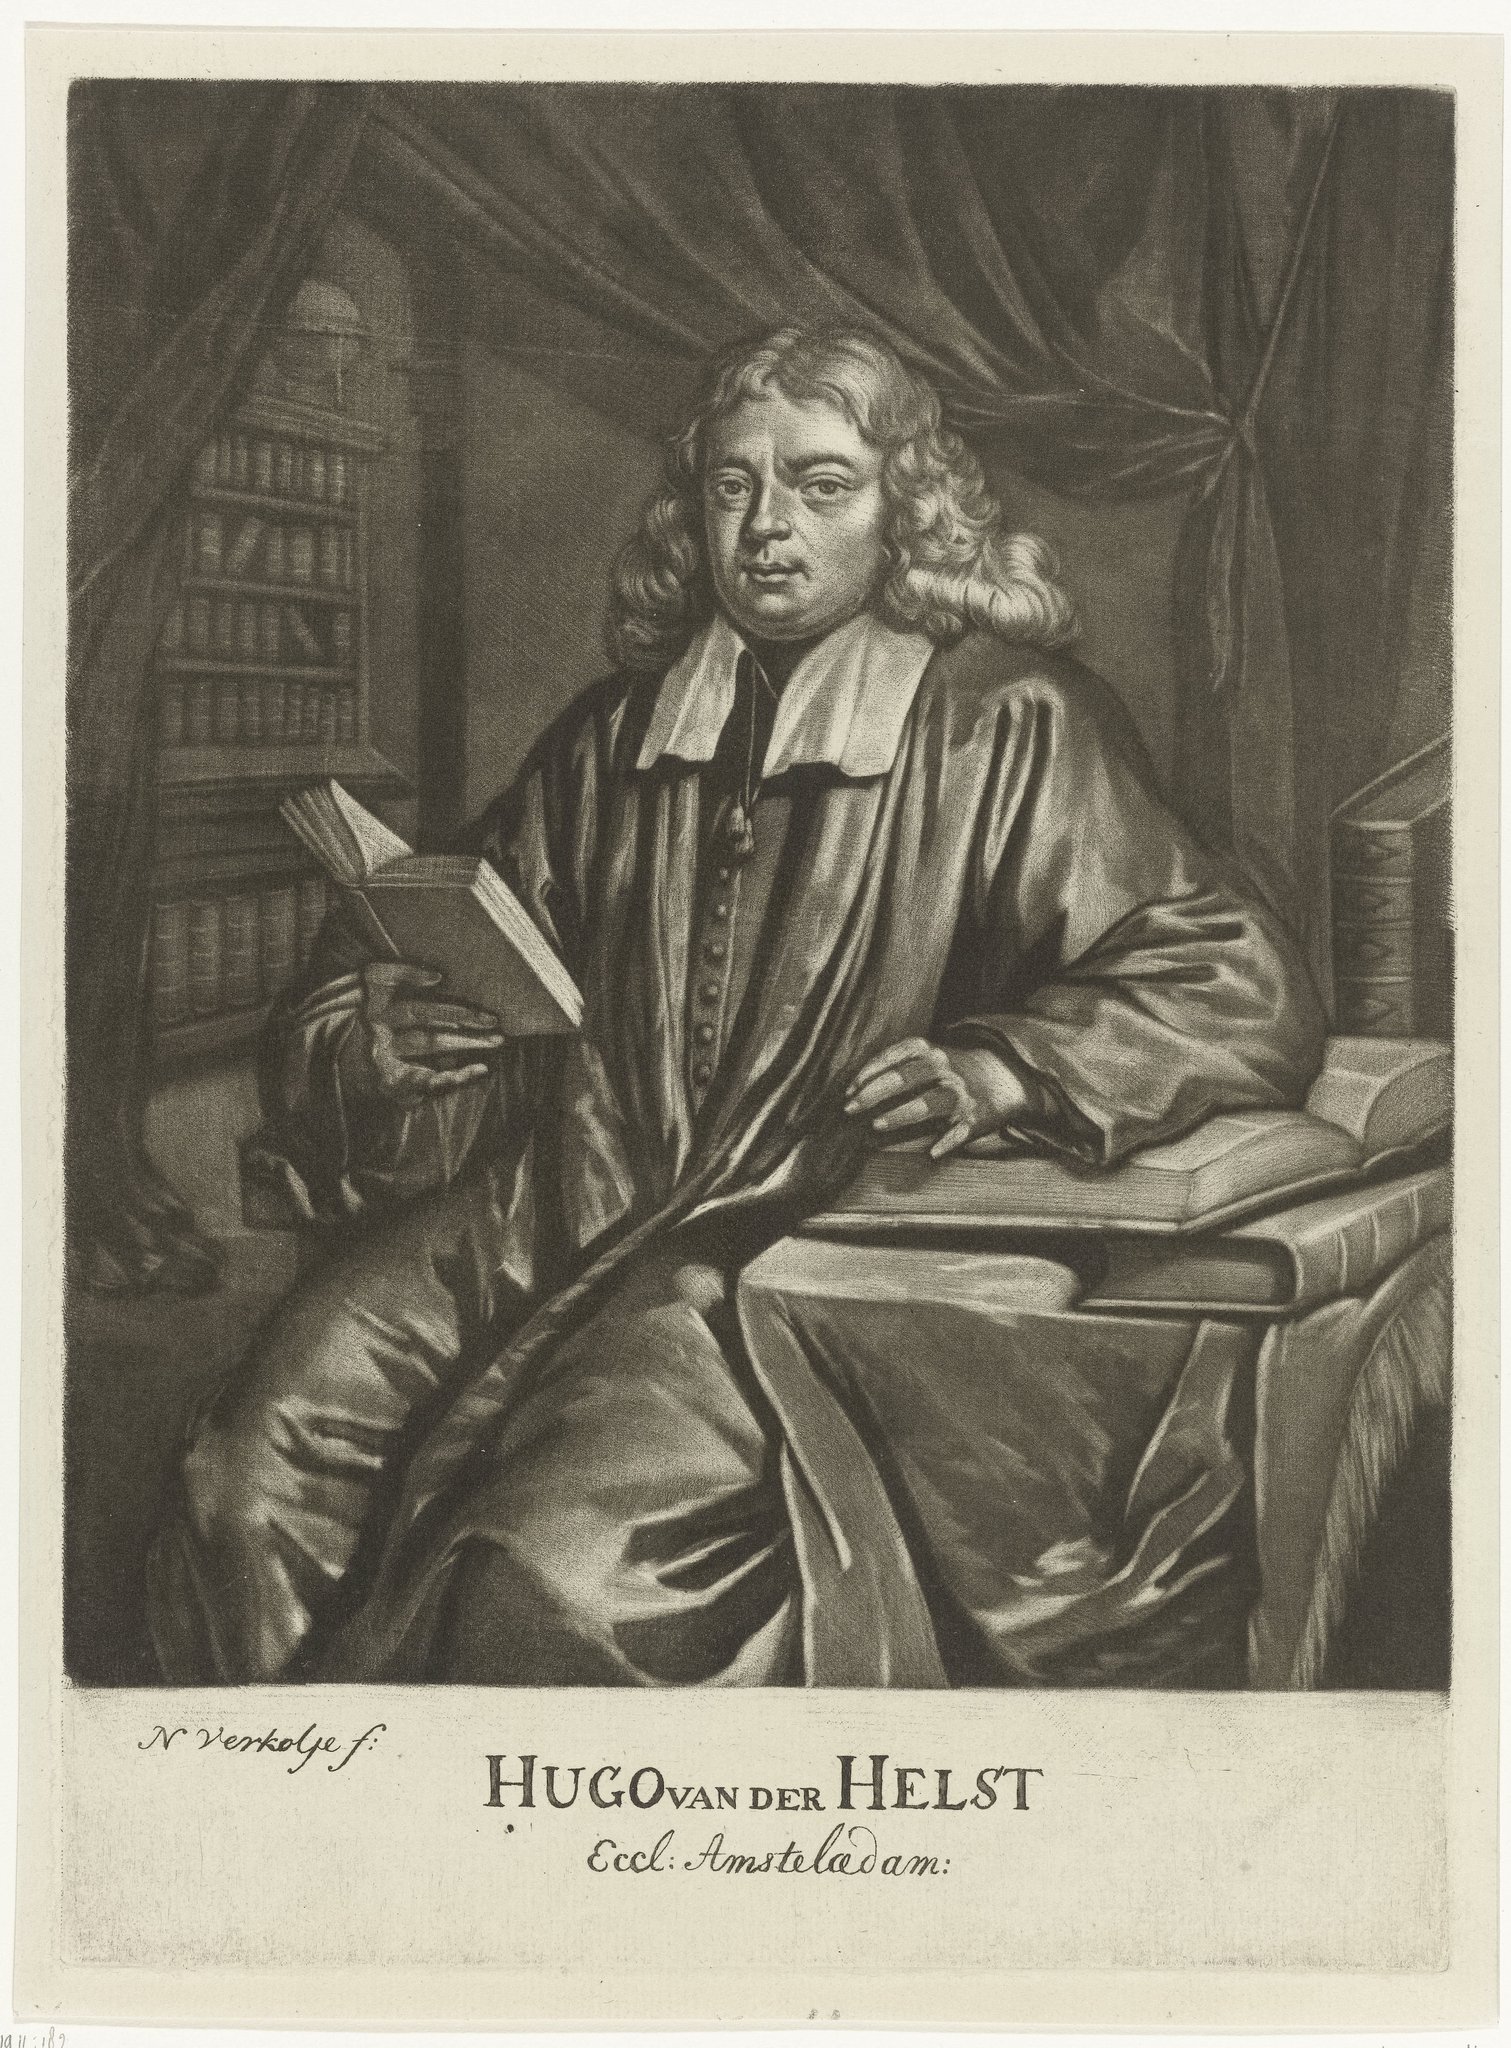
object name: print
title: Portret van Hugo van der Helst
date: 1683-1746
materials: paper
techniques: mezzotint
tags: reading, book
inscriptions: collector's mark: Lugt 2228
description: De predikant Hugo van der Helst zit in zijn studeerkamer een boek te lezen. Op de achtergrond een boekenkast.